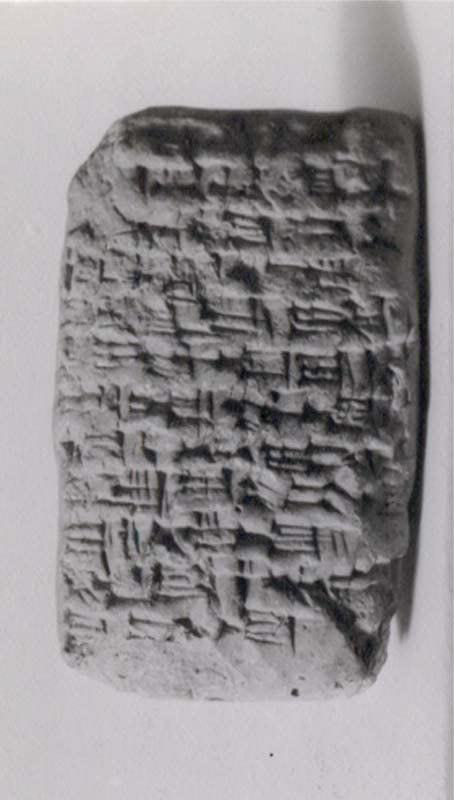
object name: cuneiform tablet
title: Cuneiform tablet: letter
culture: achaemenid or babylonian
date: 700-301 BCE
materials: clay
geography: mesopotamia